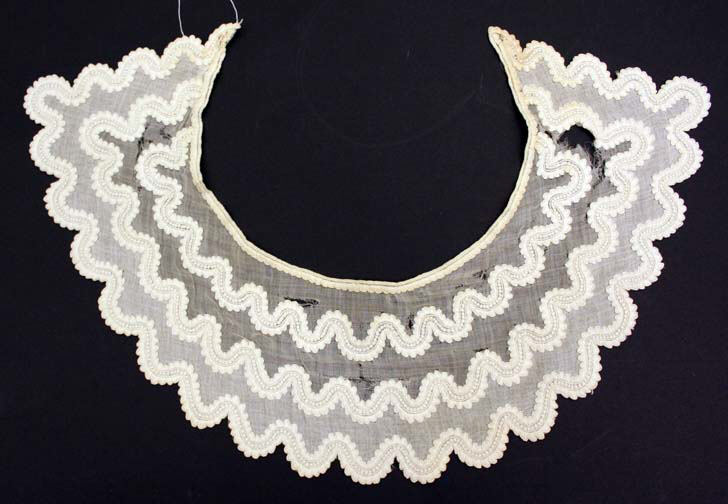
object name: collar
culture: american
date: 1860-1869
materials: cotton